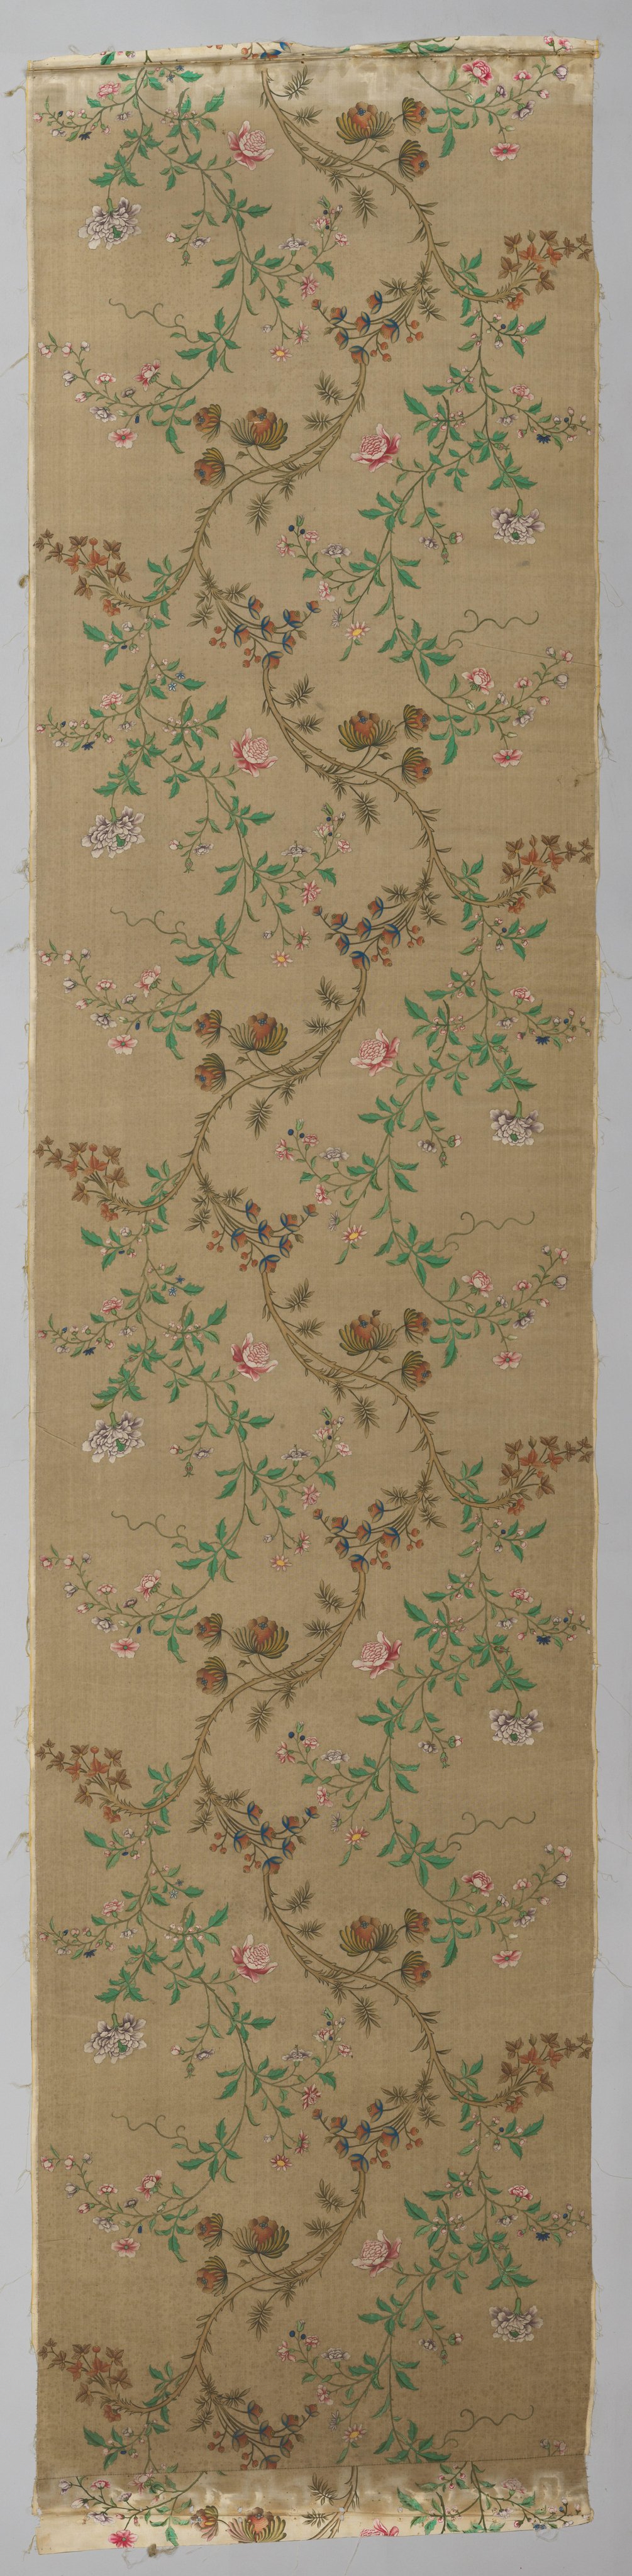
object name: interieuronderdeel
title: Bespanningsstof met decor van takken, bladeren, bloemen en vruchten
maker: Anonymous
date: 1750-1790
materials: paint, silk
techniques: printing, weave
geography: china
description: Een baan veelkleurig beschilderde creme bespanningsstof van zijde. Beschrijving zie A.